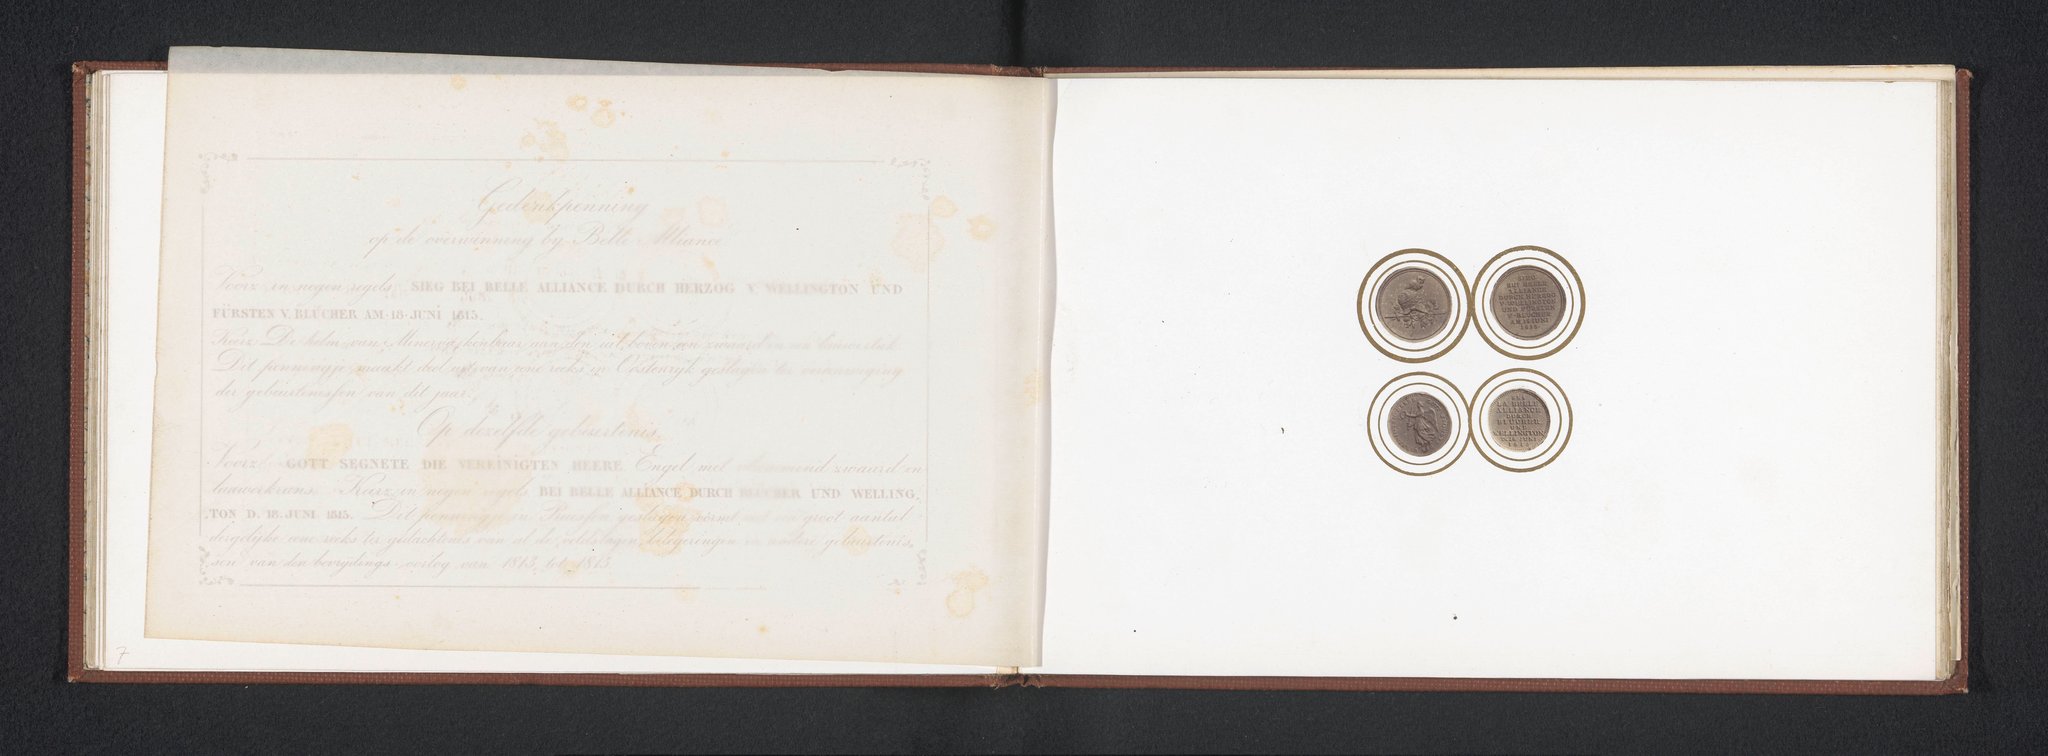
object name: page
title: Vier afbeeldingen van gedenkpenningen ter nagedachtenis aan de overwinning bij Belle Alliance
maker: willem matla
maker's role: fotograaf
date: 1865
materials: paper, photographic support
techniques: albumen print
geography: the hague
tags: garland, wreath, memorial medal, adult man (+ sideview, profile), angels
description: Linksboven een keerzijde met de helm van Minerva en een uil, rechtsboven een voorzijde met een tekst, linksonder een keerzijde met een engel met een lauwerkrans en een brandend zwaard, rechtsonder een voorzijde met een tekst.